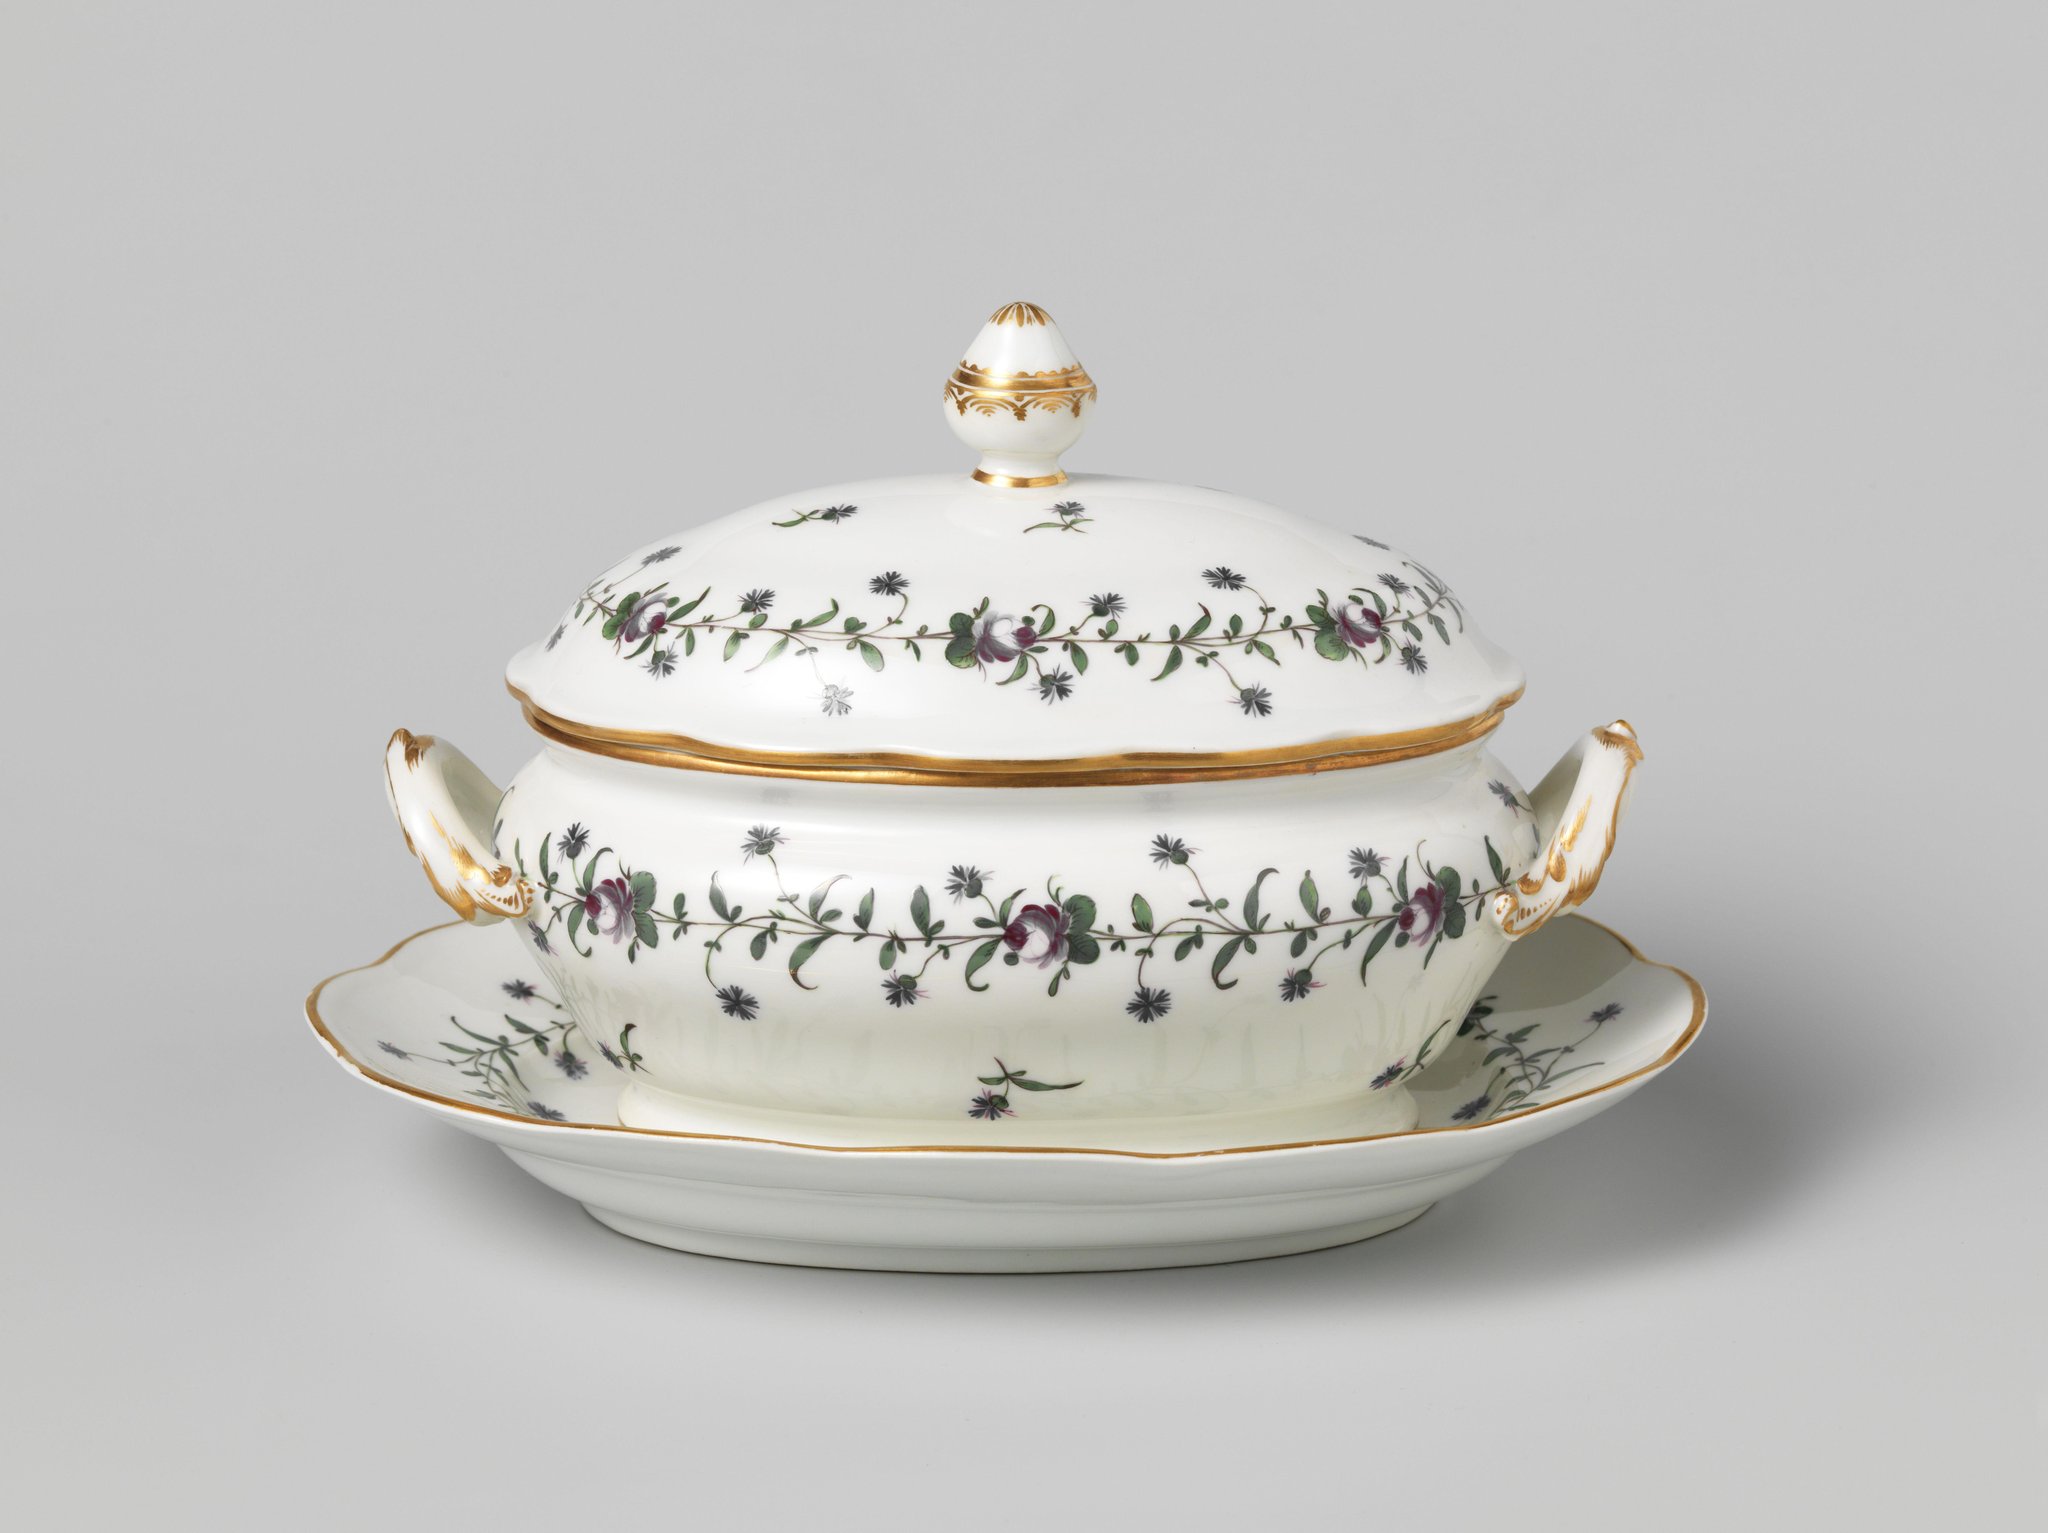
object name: tureen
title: Terrine met bladslingers, bloemen en strooibloemen.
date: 1774-1784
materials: porcelain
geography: loosdrecht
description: Terrine van porselein. Beschilderd met bladslingers waartussen bloemen en losse strooibloemen en gouden biezen. De terrine en onderschotel zijn gemerkt met MOL, het deksel is gemerkt met MOL en Amstel.